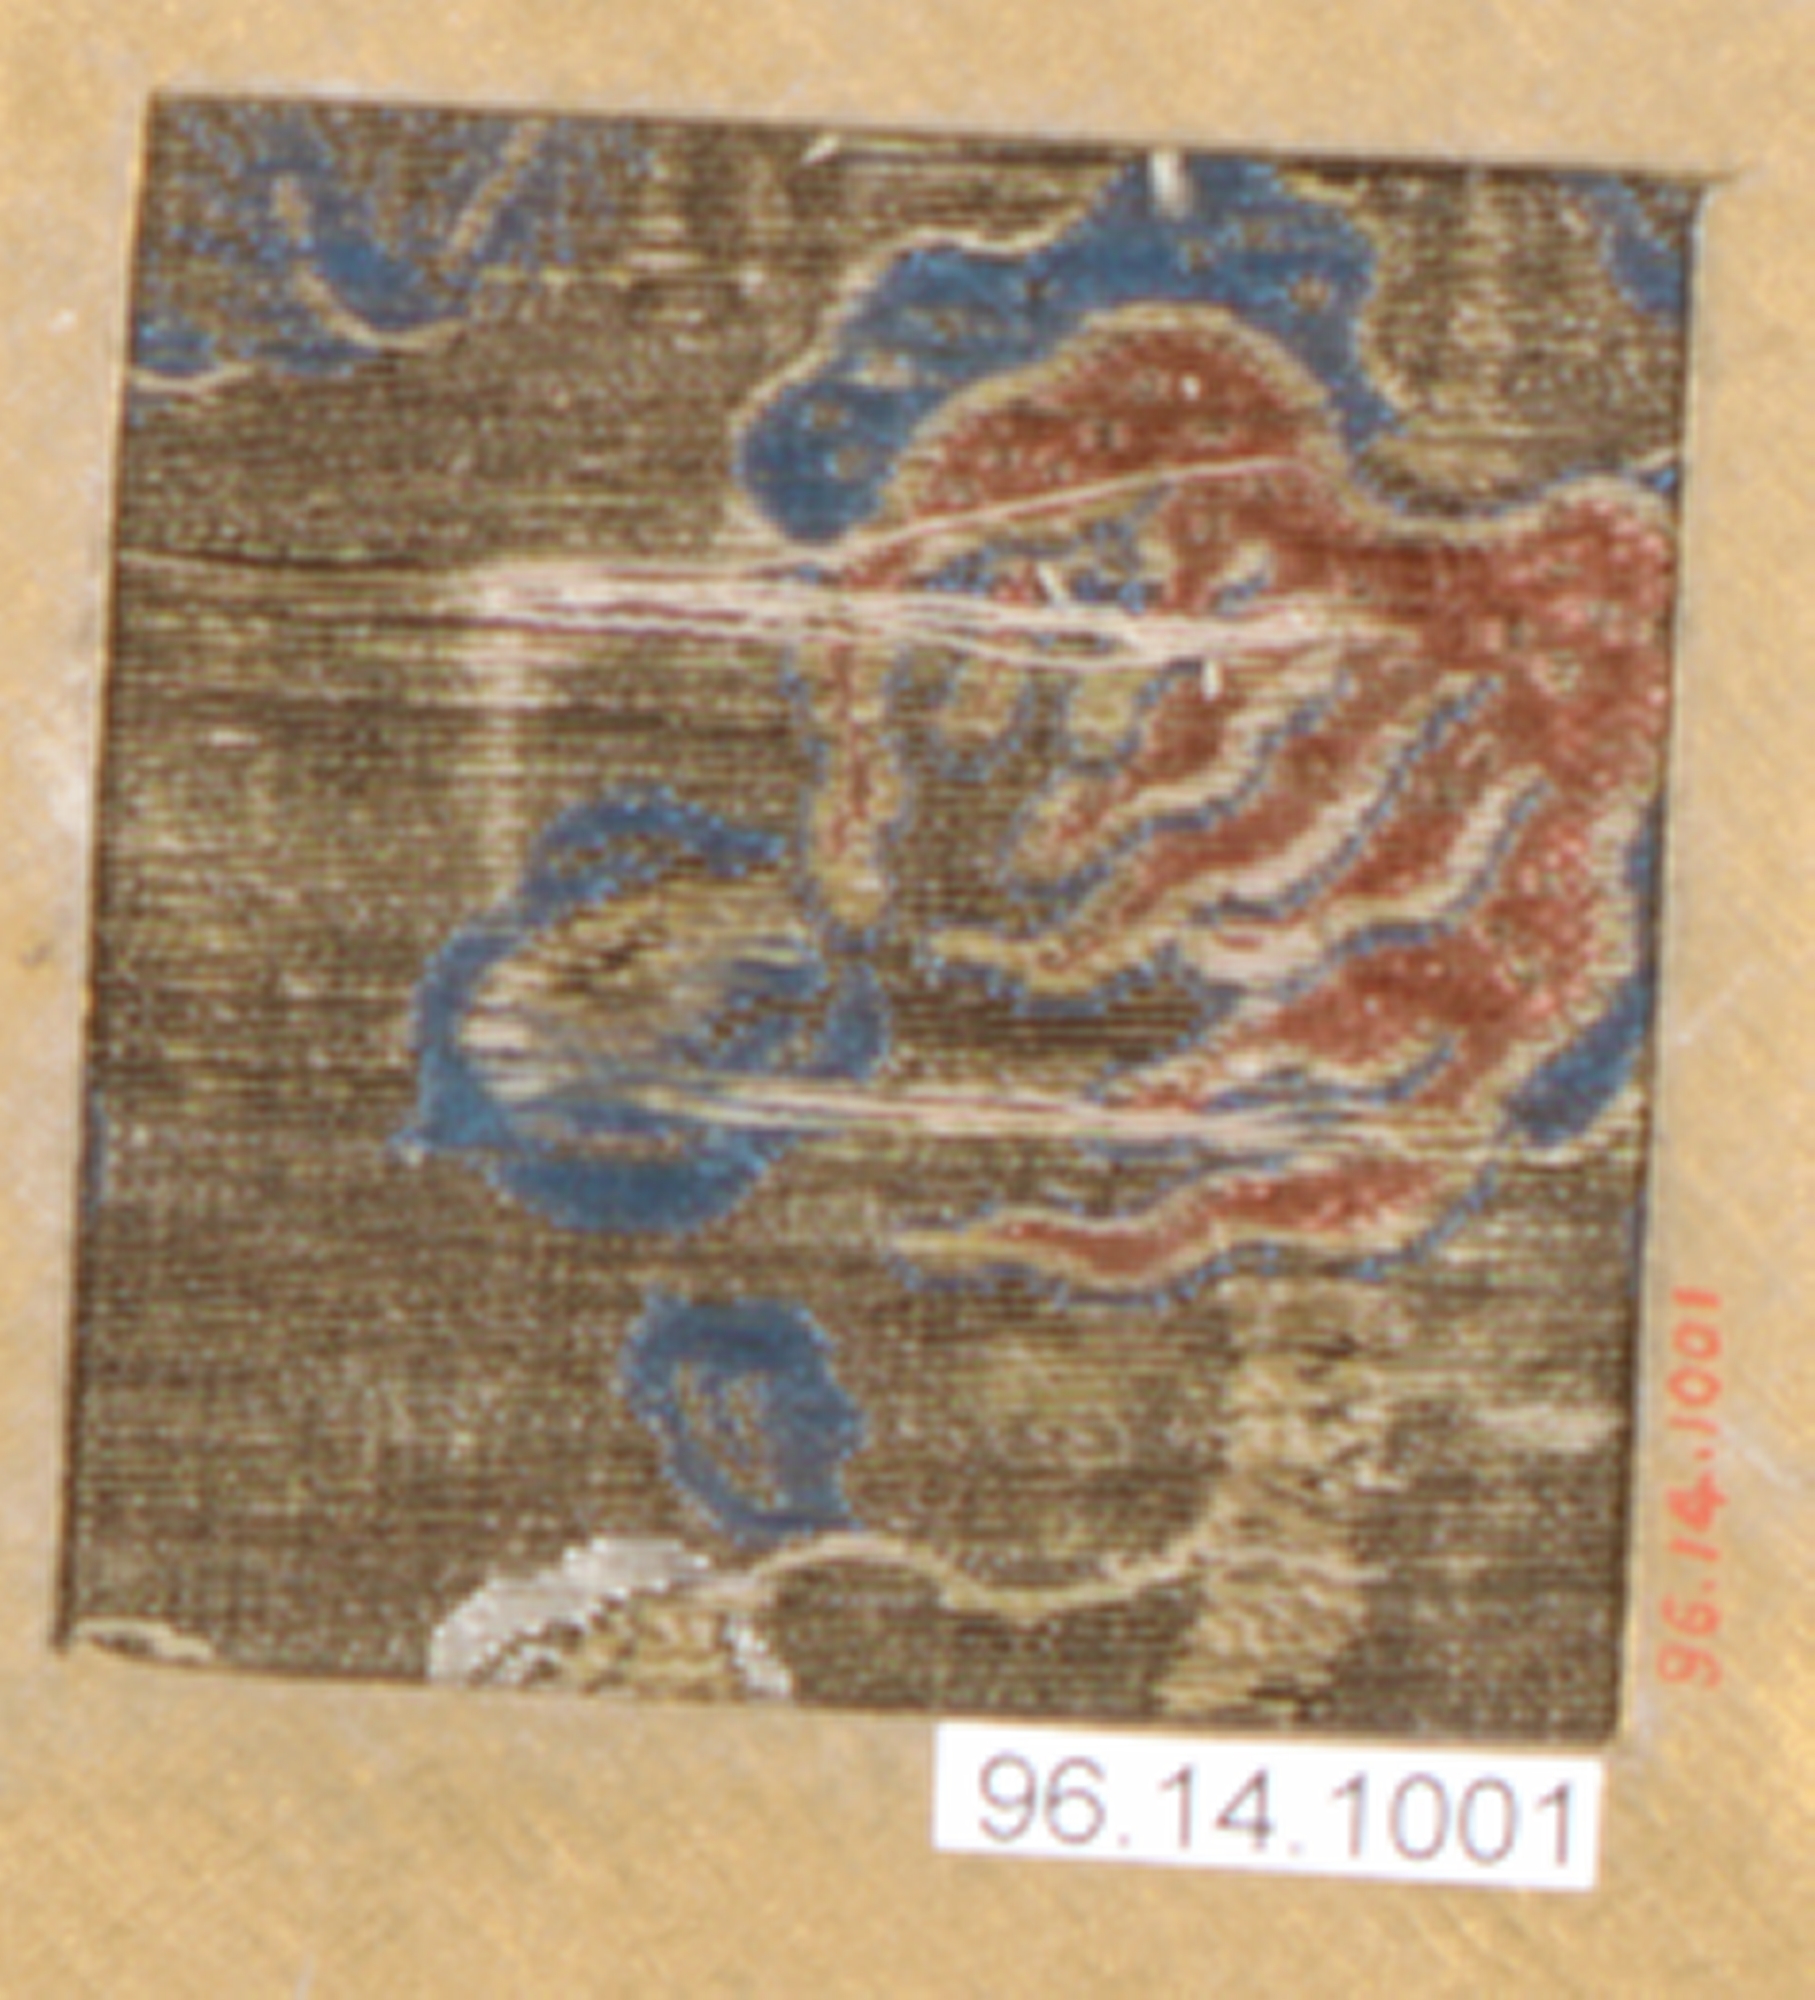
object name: piece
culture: japanese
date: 1701-1900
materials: silk